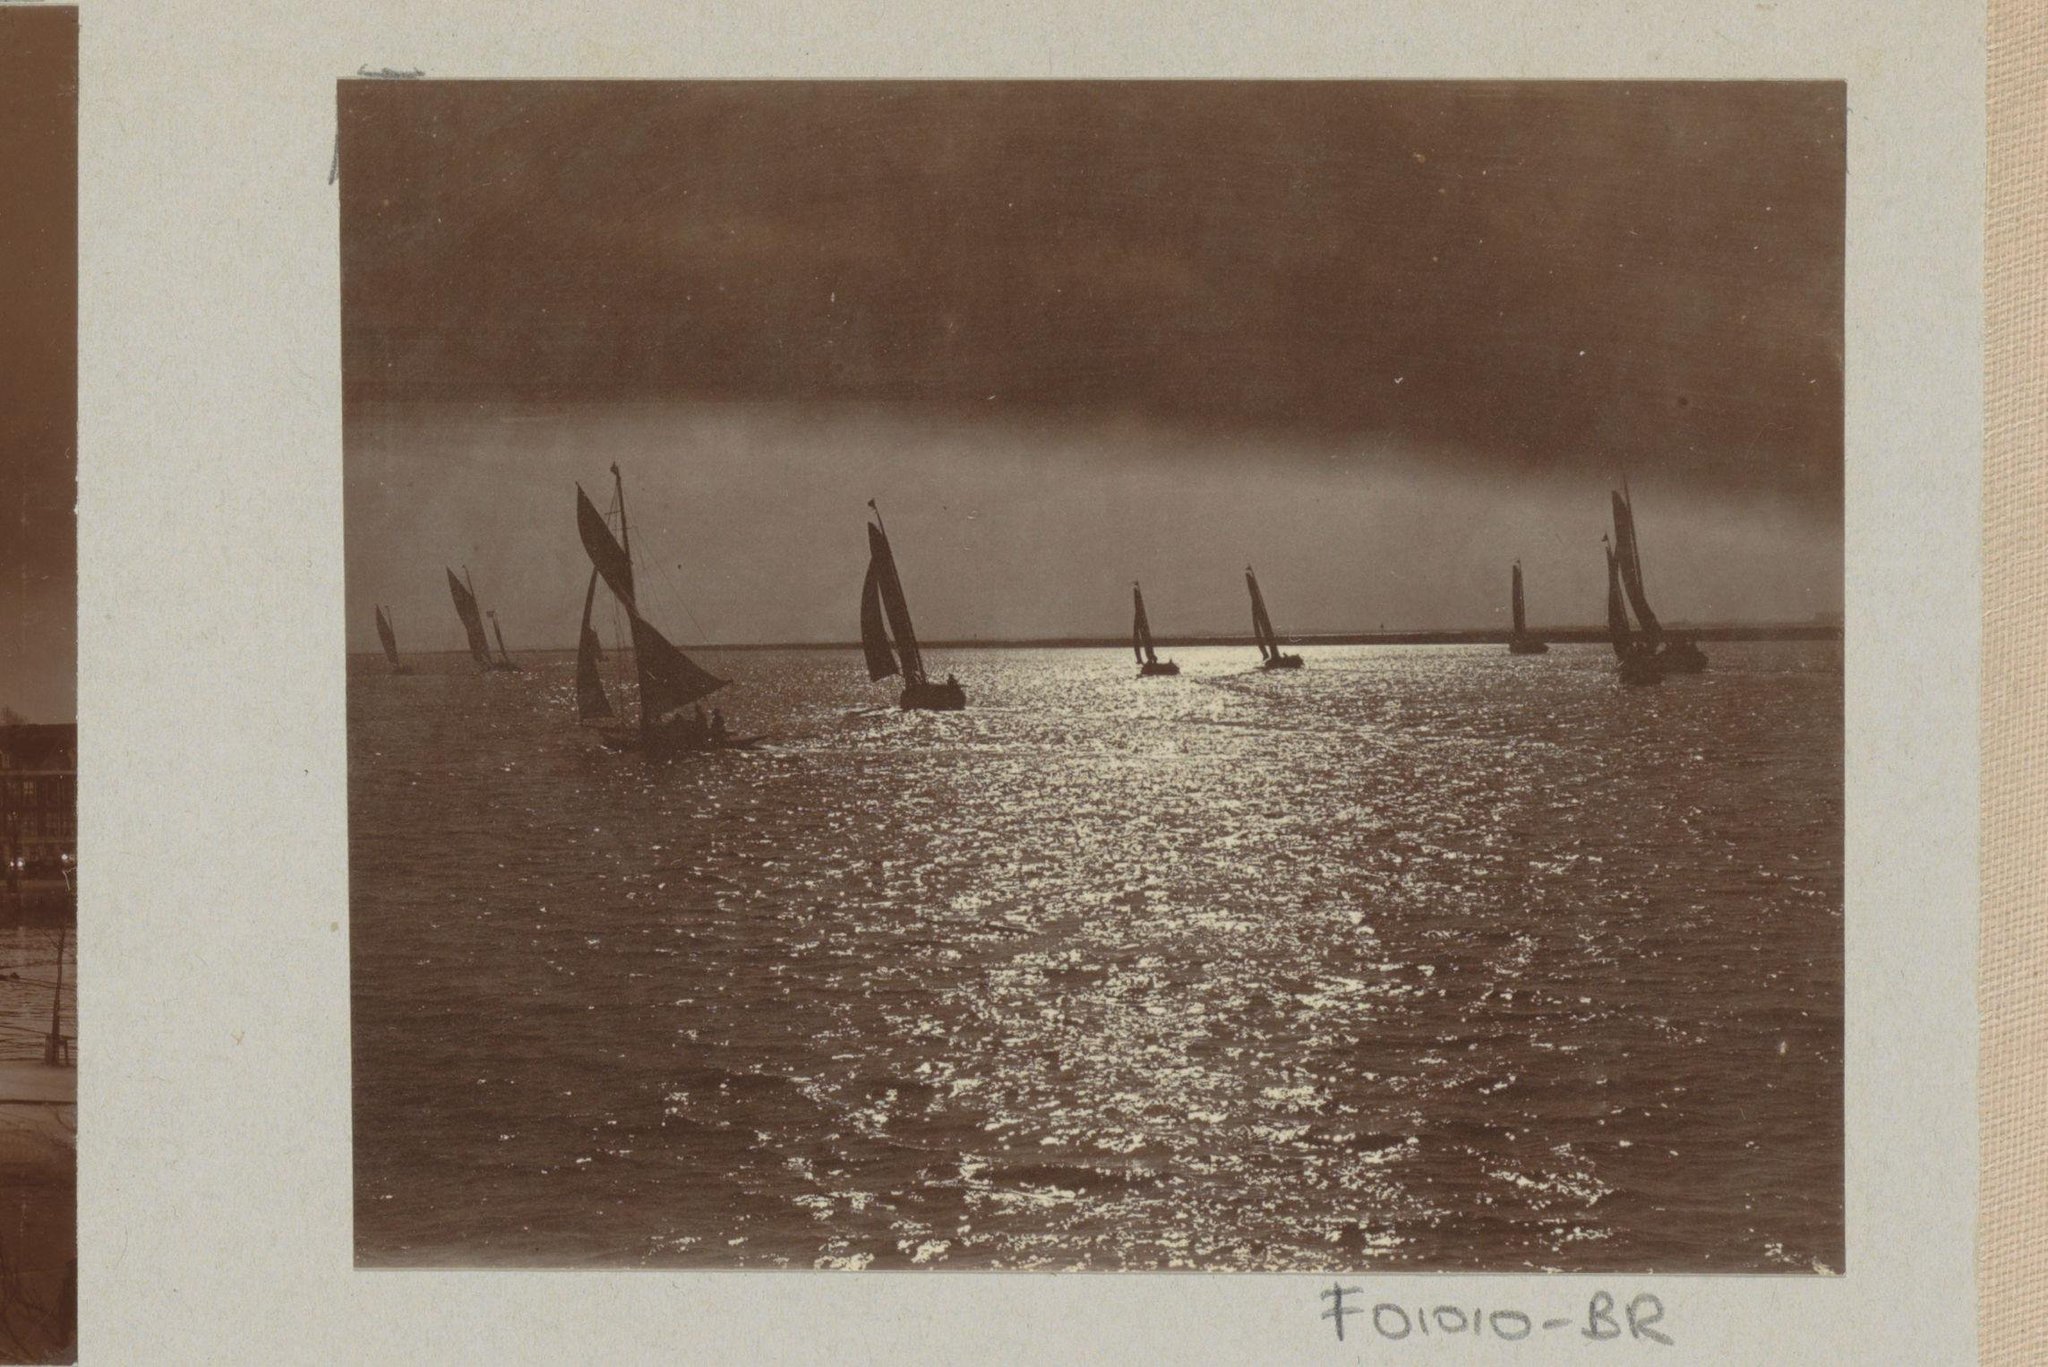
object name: photograph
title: Zeilschepen op het water bij avond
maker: Anonymous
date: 1900-1910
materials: photographic support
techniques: daylight paper print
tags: sailing-ship, sailing-boat, evening, sea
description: Onderdeel van Familiealbum met onder meer foto's van Wijnhandel Kraaij & Co. Bordeaux-Amsterdam.